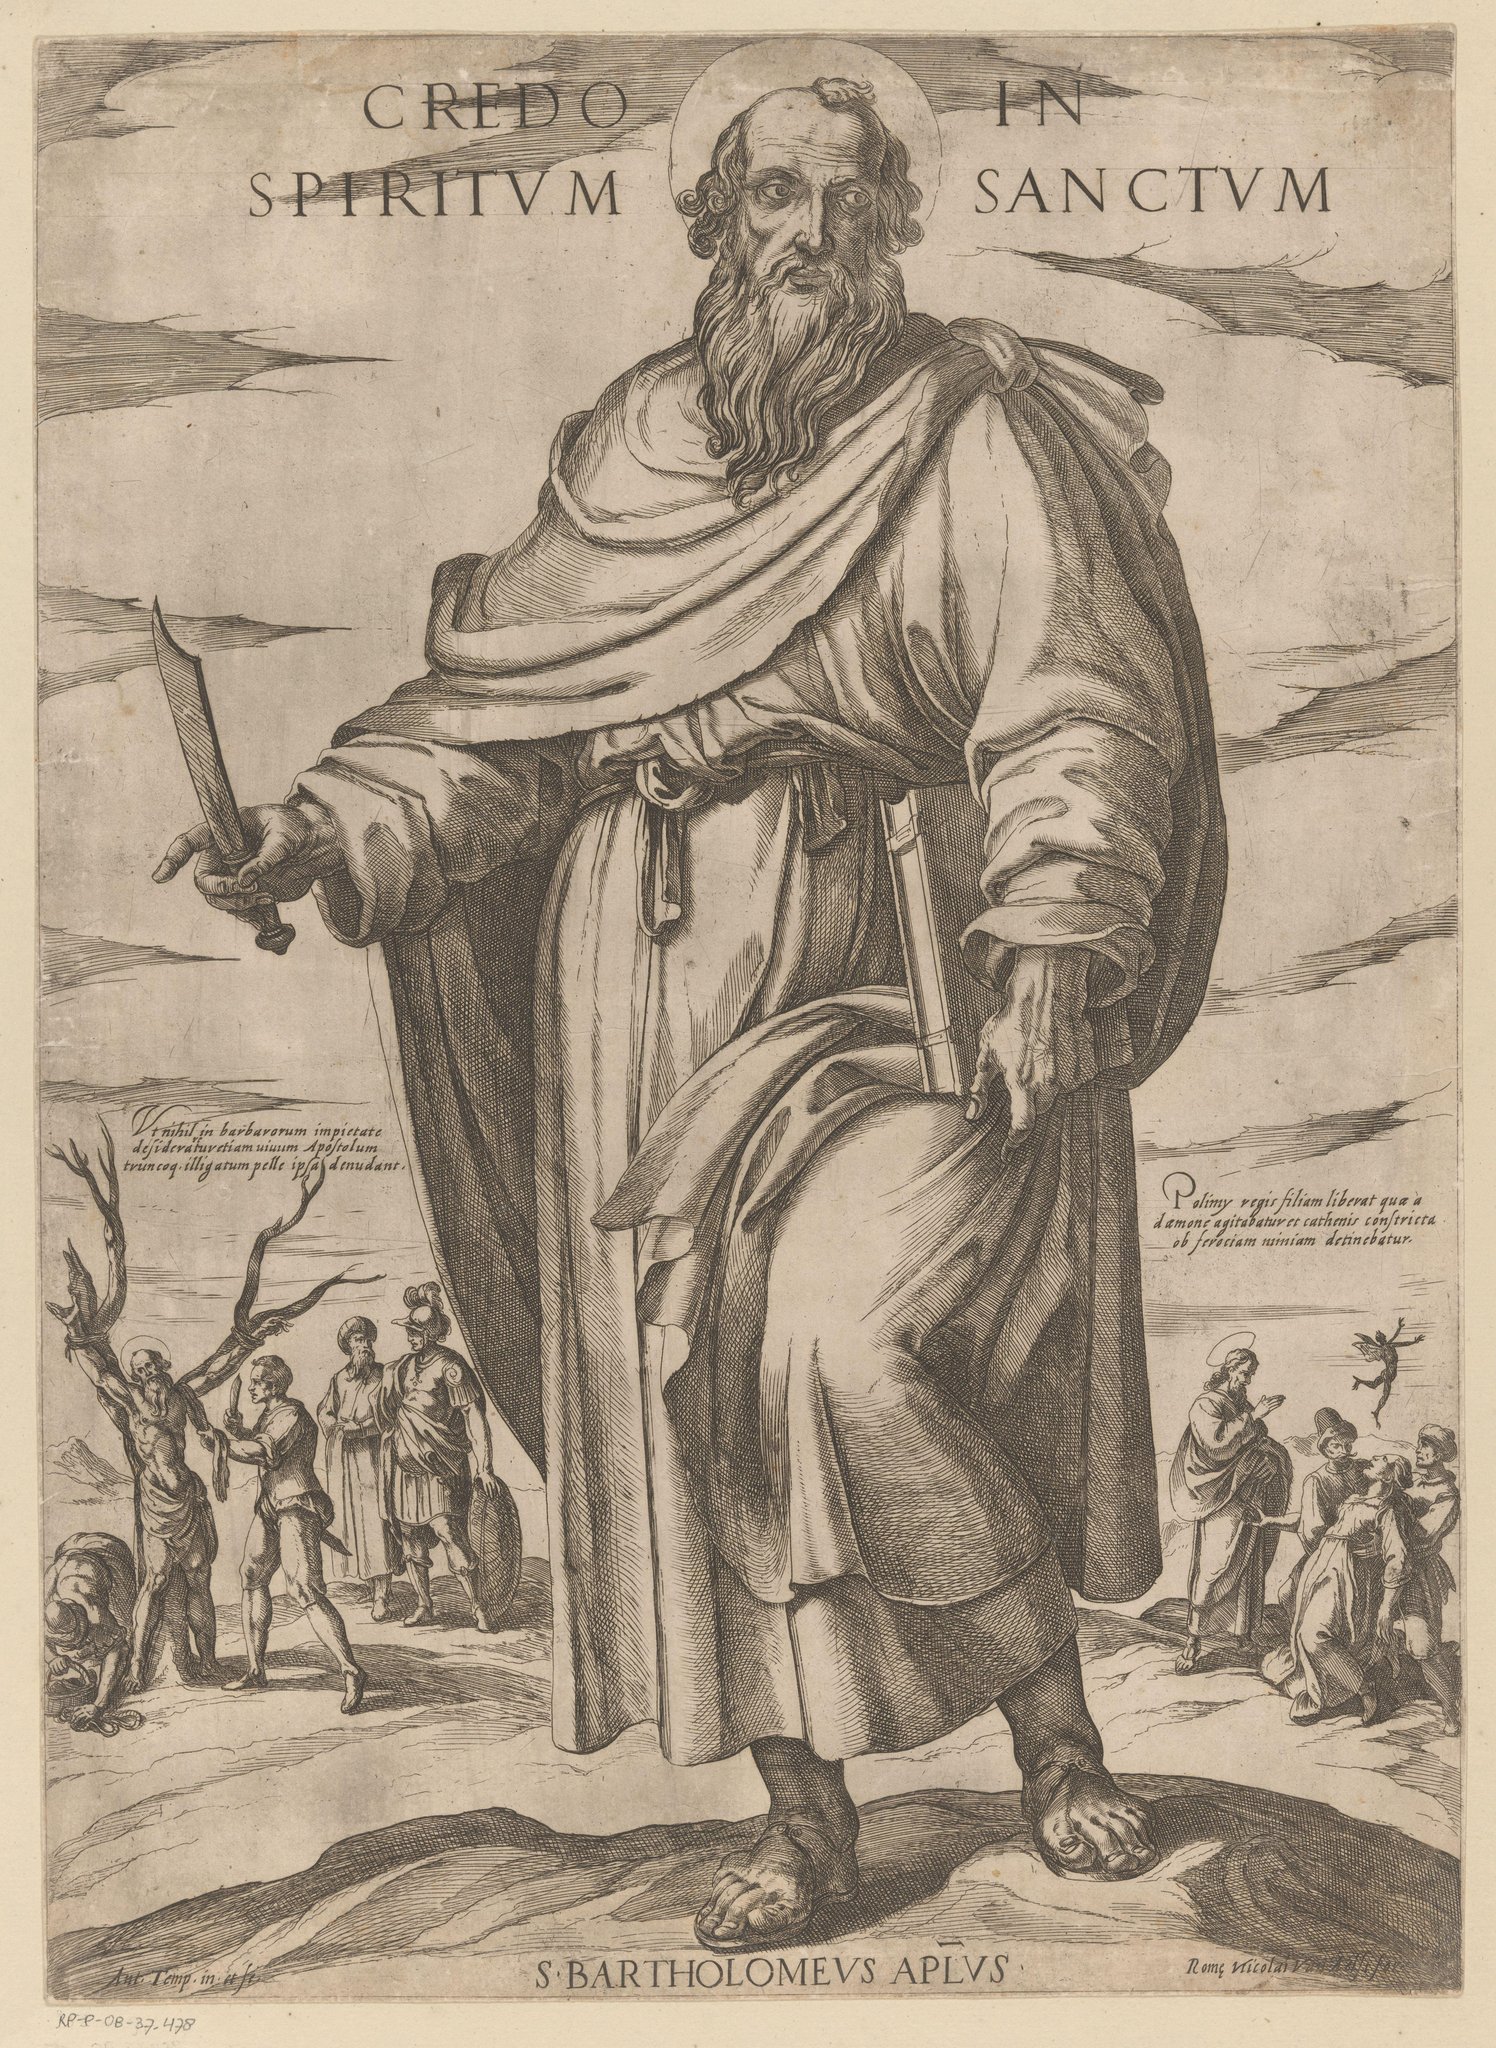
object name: print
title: De heilige Bartolomeüs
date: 1565-1630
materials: paper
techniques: etching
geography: italy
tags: the apostle bartholomew; possible attributes: book, devil or dragon at feet, knife, scroll, flayed skin, staff, bartholomew flayed alive, bartholomew casting a demon out of a woman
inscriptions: collector's mark: Lugt 240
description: De heilige Bartolomeüs met boek en dolk. Op de achtergrond links wordt de heilige Bartolomeüs gevild. Op de achtergrond rechts verdrijft Bartolomeüs een demoon uit een bezeten vrouw.